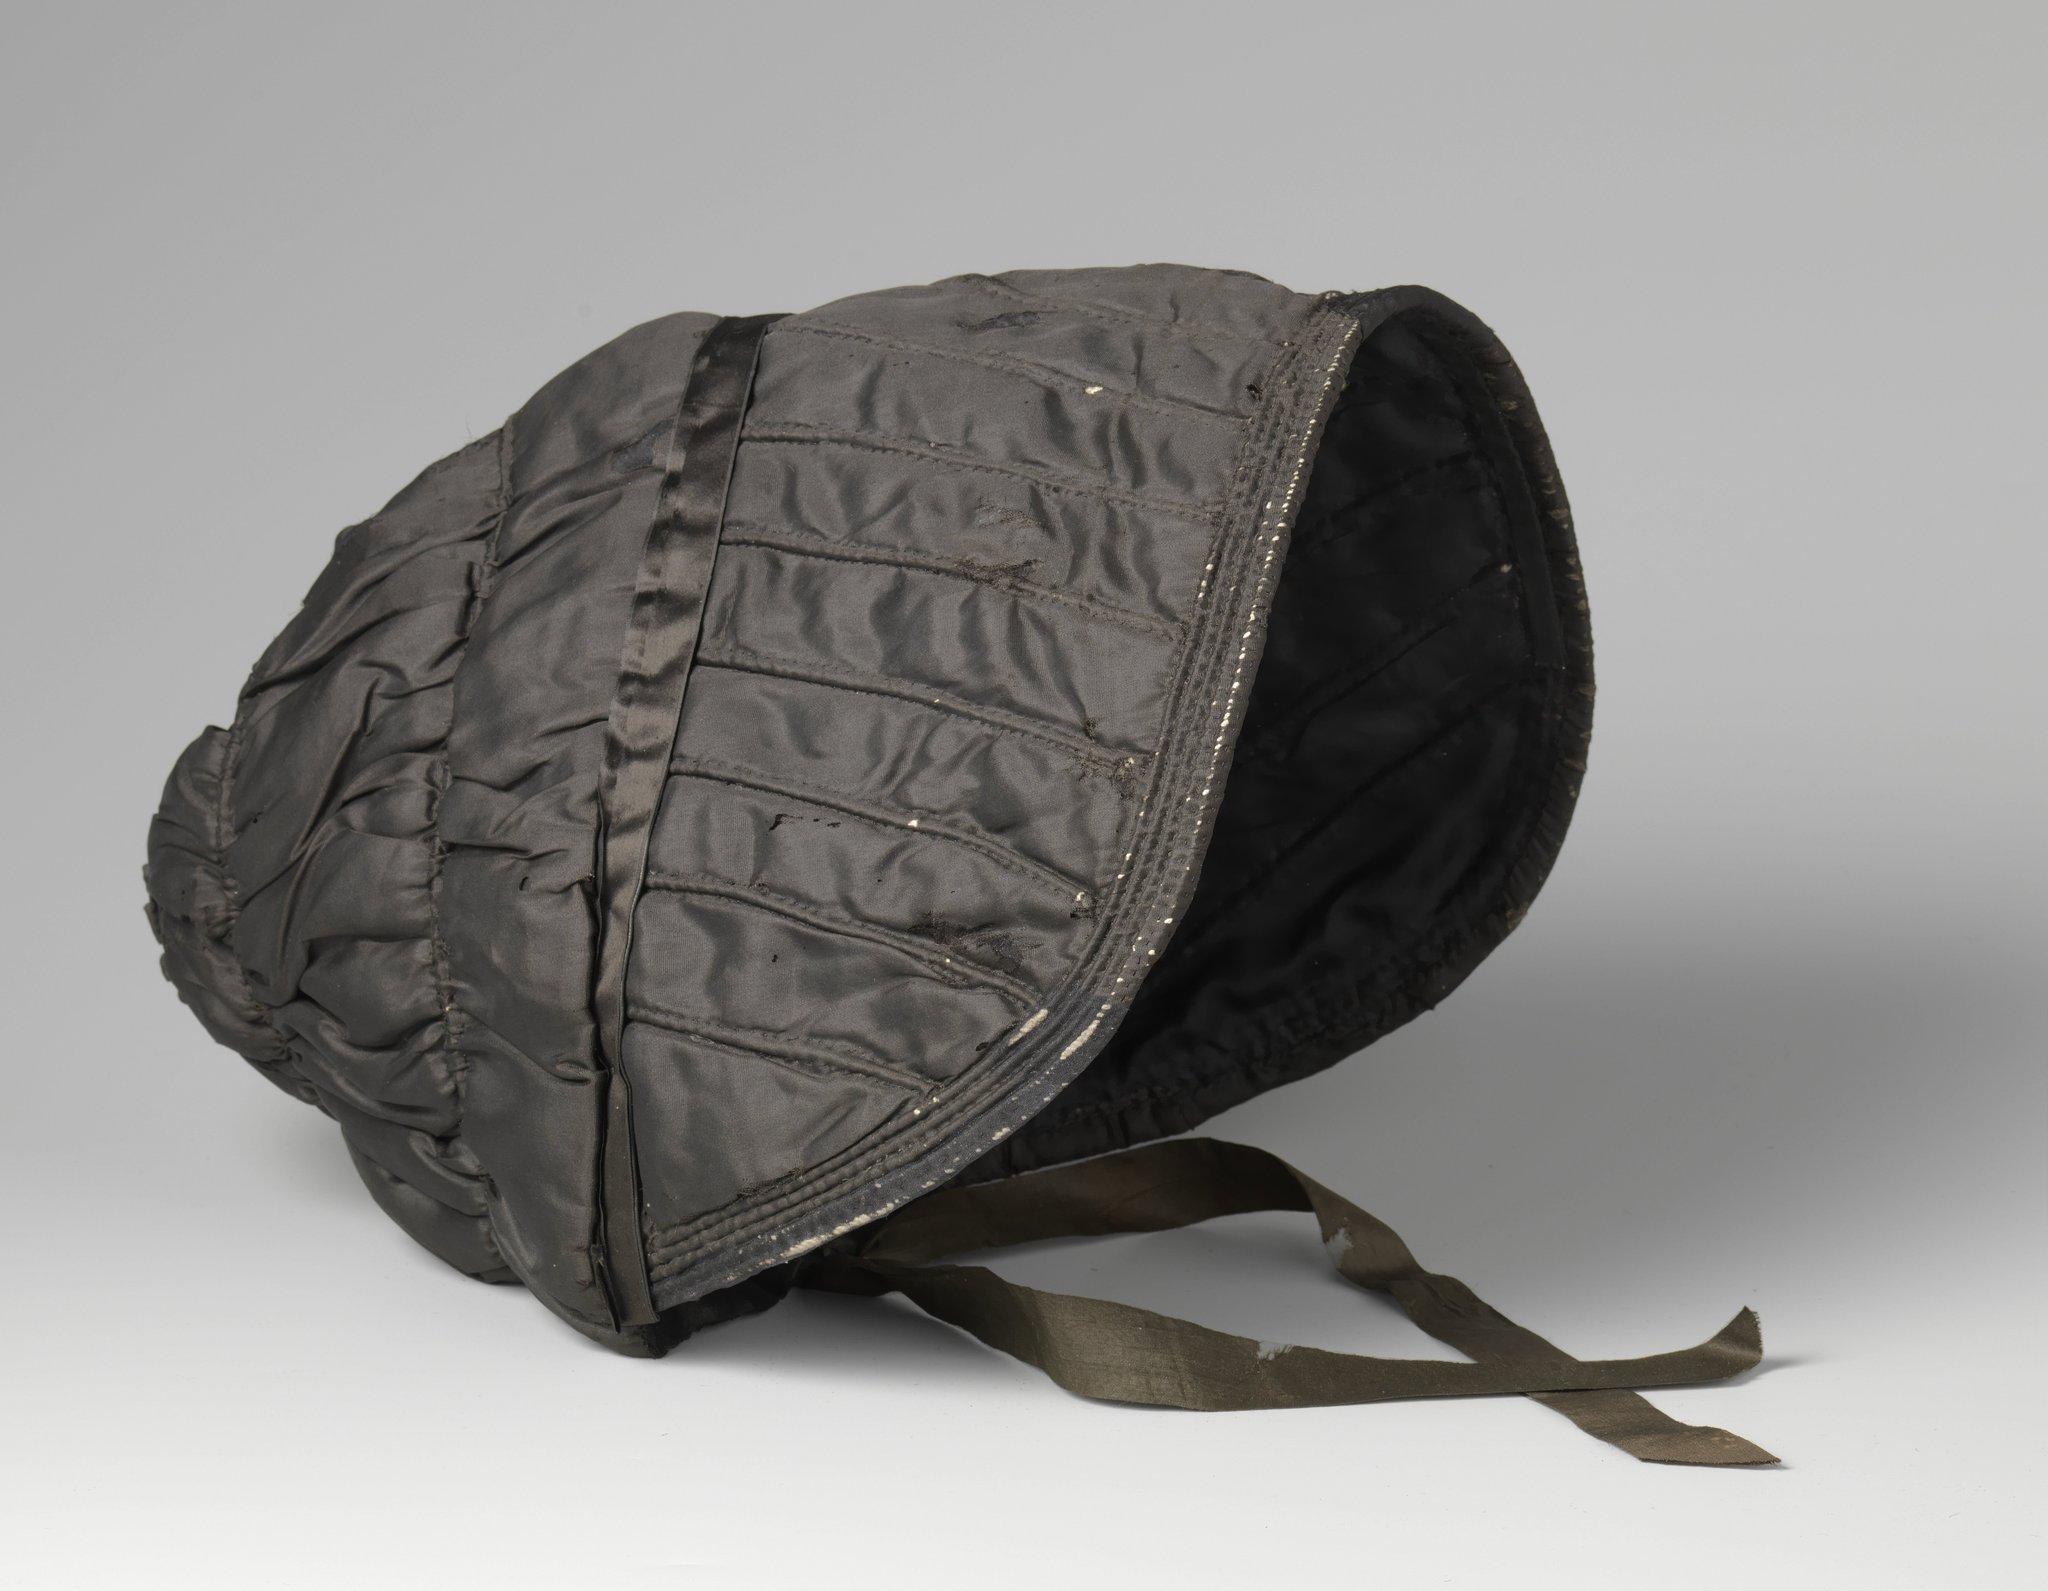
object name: bonnet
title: Poke bonnet (capote)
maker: Anonymous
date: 1805-1815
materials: fiber, textile, silk, wool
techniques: padding, spinning, twining, weave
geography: netherlands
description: The first poke bonnets, or capotes, made their appearance around 1805 and remained in fashion until around 1815. The broad brim, which framed the wearer’s face and straight hairstyle, severely restricted her field of vision. She had to turn her head in order to look sideways.